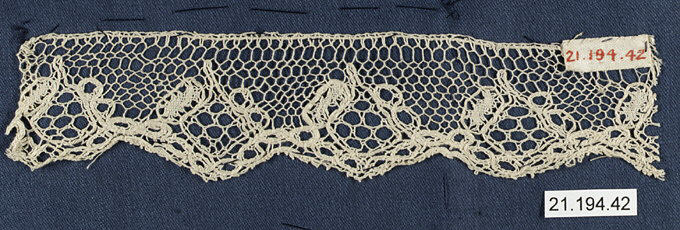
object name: piece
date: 1801-1900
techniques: lace